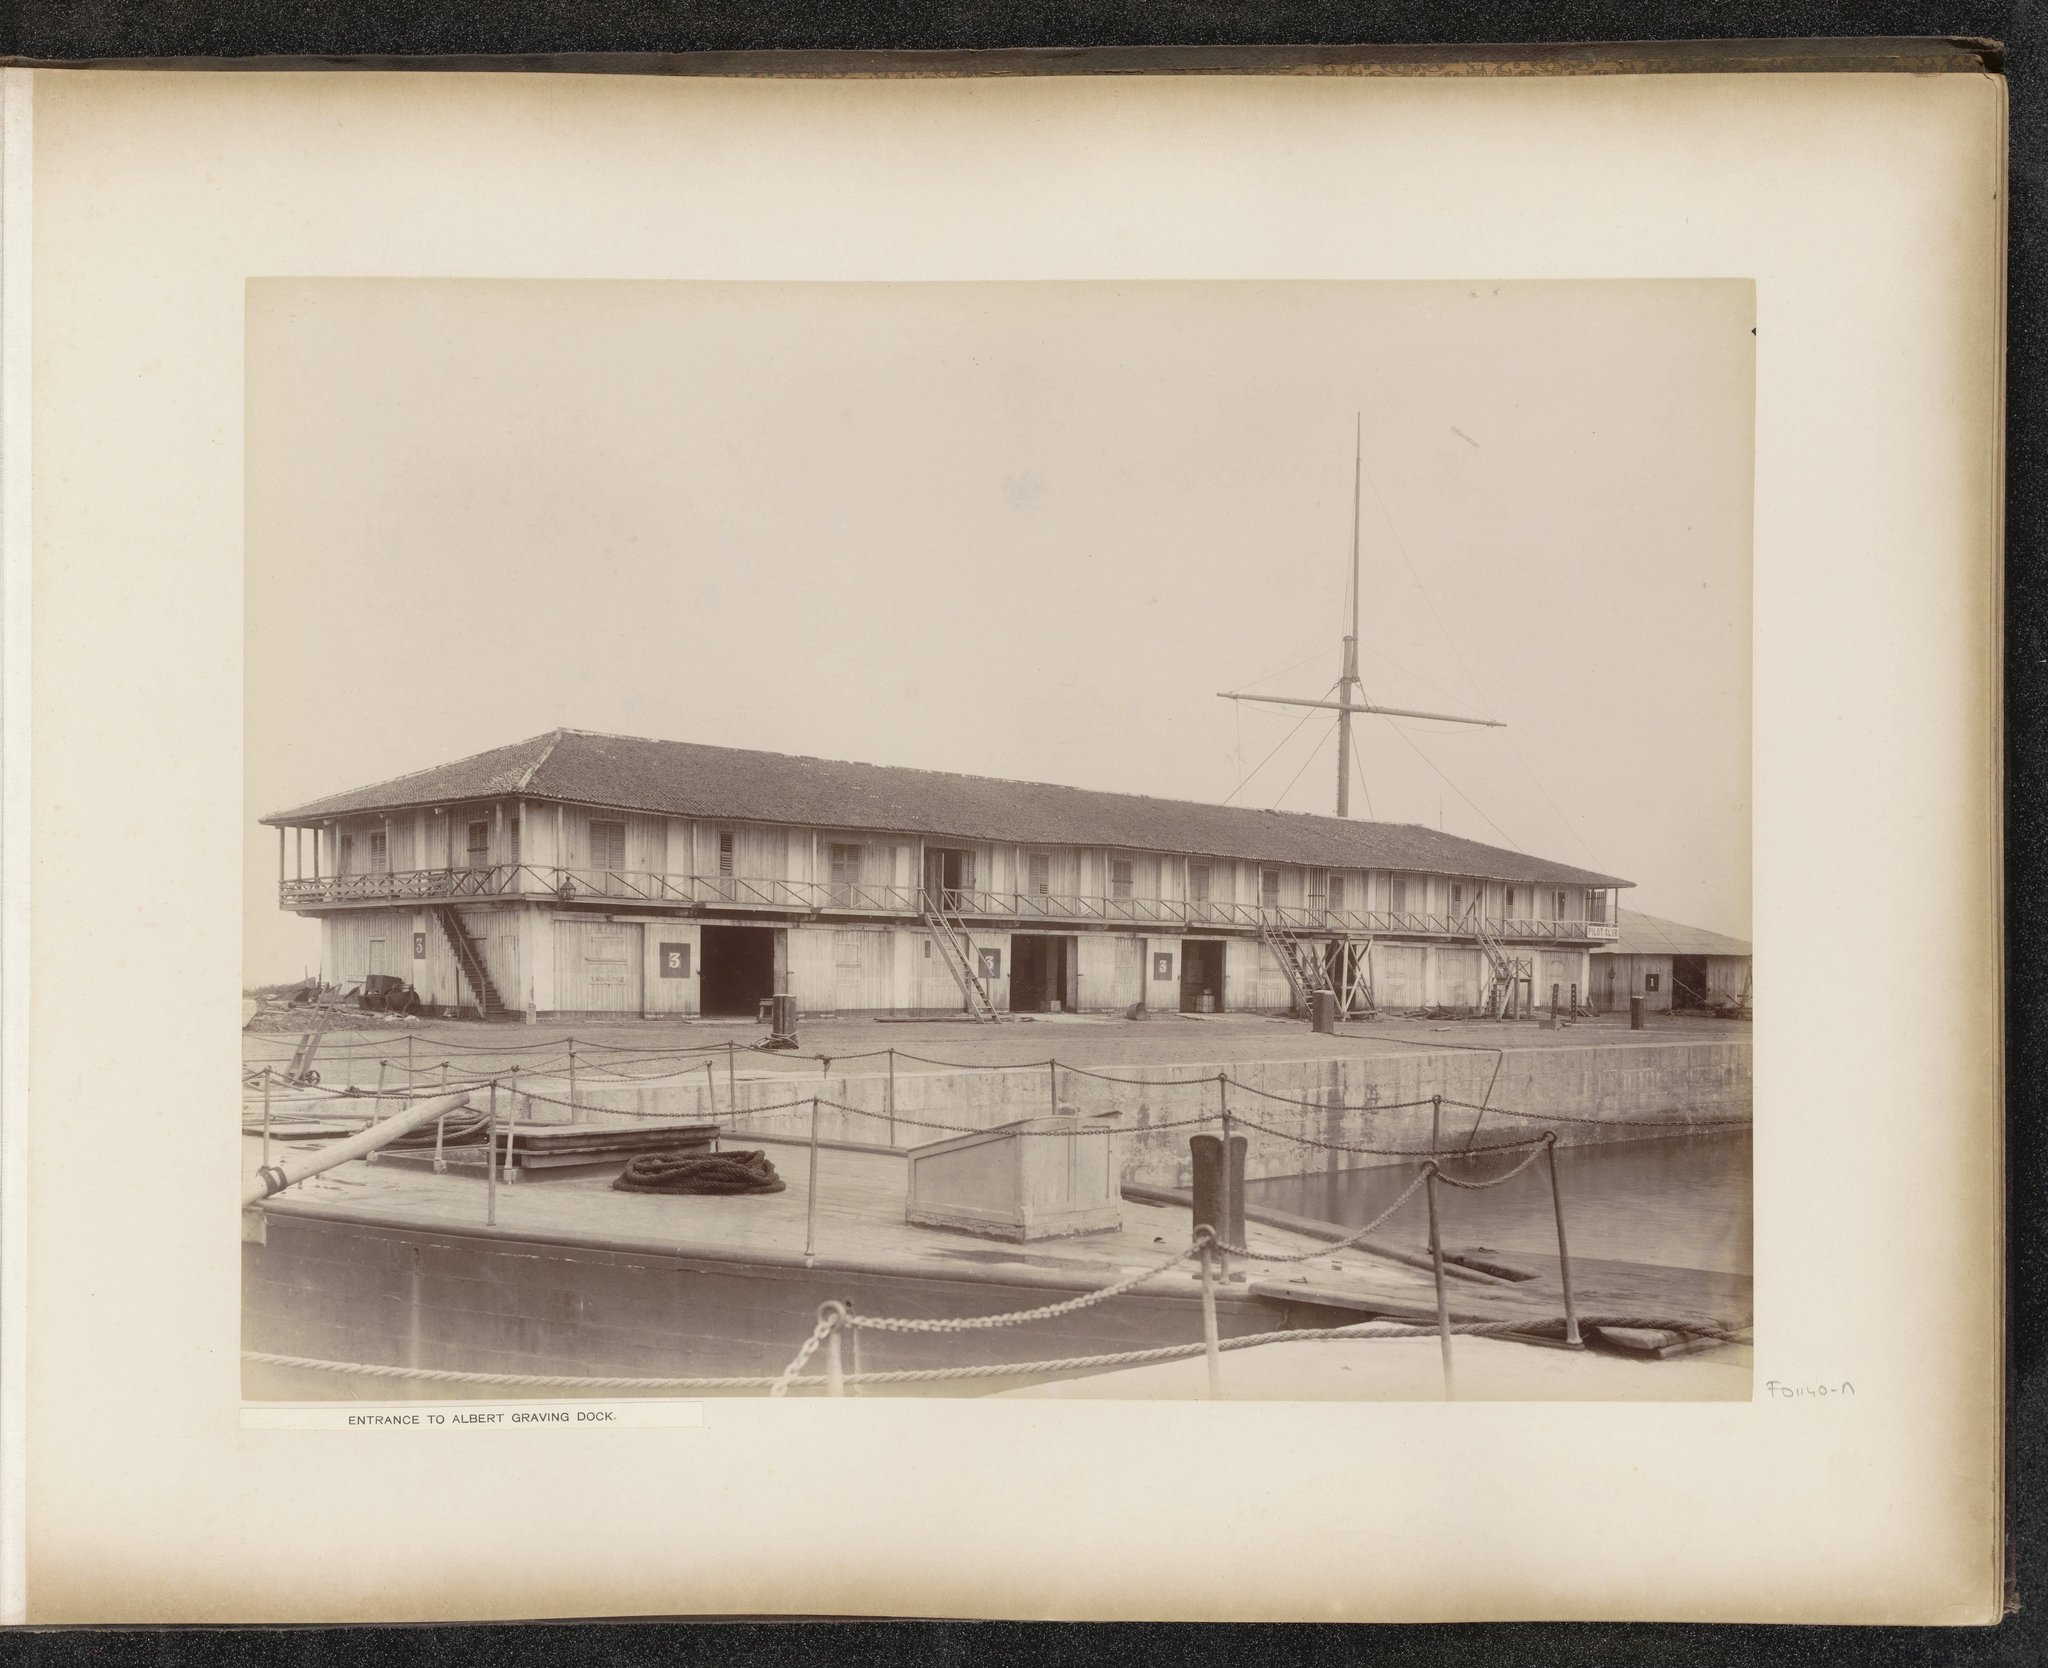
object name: photograph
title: Ingang van het Albert-reparatiedok van de Tanjong Pagar Dock Co. Ltd. in Singapore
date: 1890-1905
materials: photographic support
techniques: albumen print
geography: singapore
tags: pier, quay, wharf, shipyard, shipdock, shipbuilding industry, singapore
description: Onderdeel van Fotoalbum van de Tanjong Pagar Dock Co. Ltd. in Singapore.